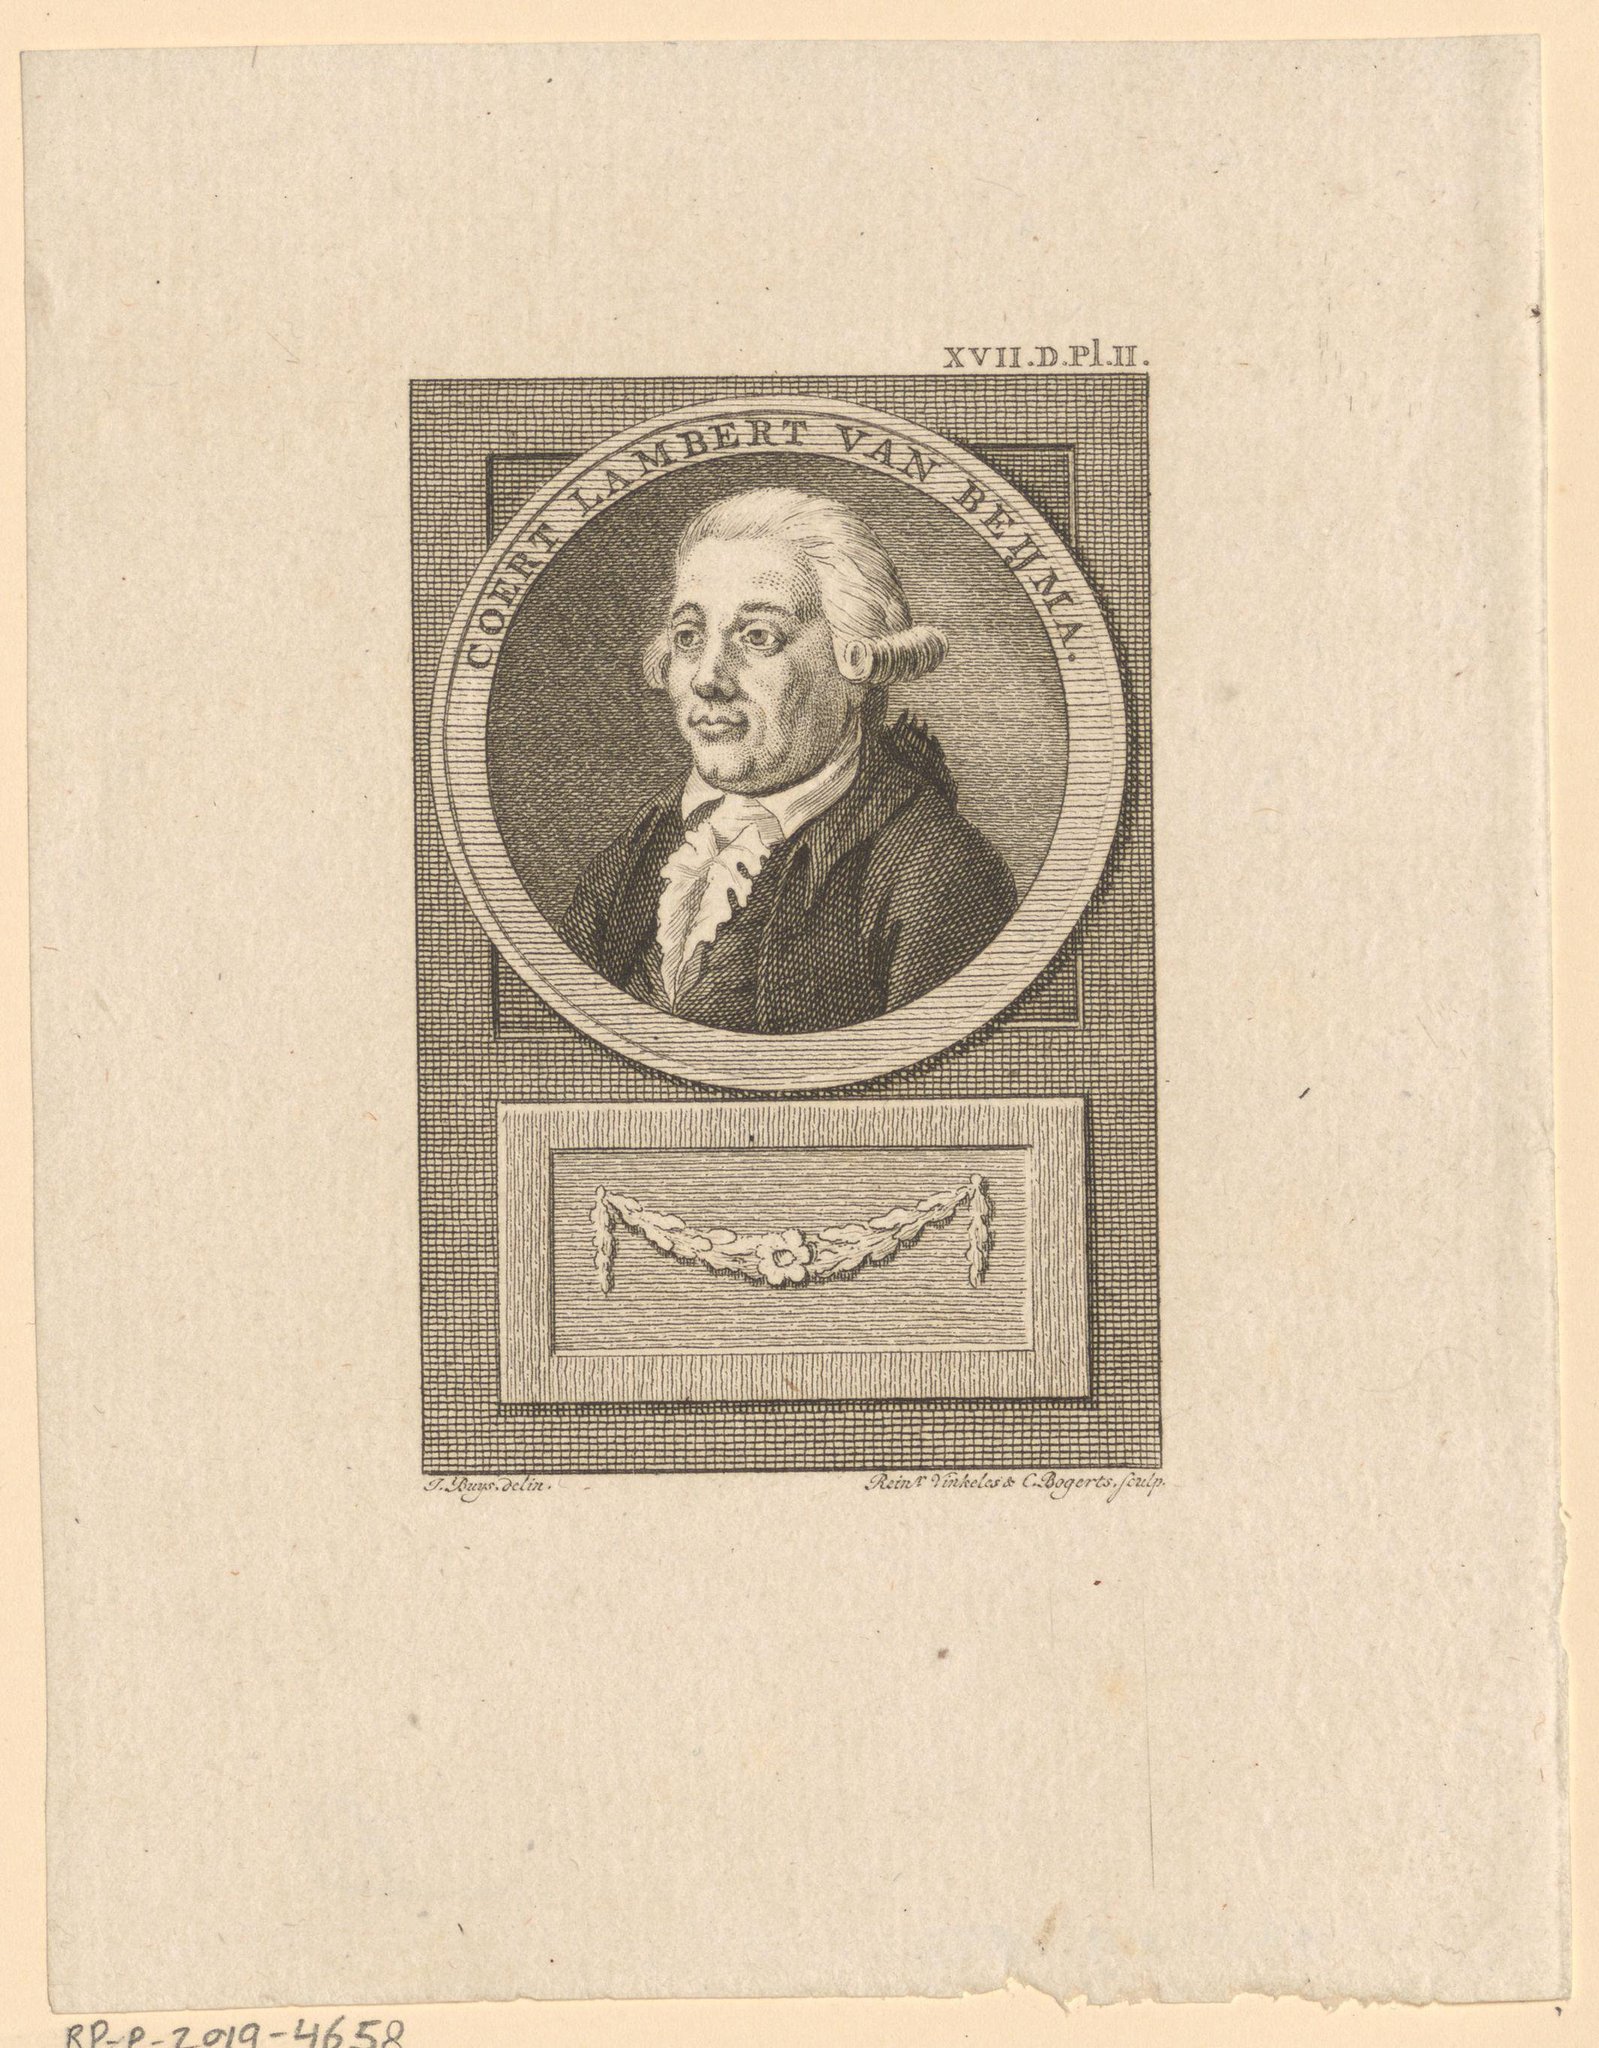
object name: book illustration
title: Portret van Coert Lambertus van Beyma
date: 1783-1795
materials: paper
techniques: engraving, etching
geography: amsterdam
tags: harlingen, historical persons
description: Prent uit: Fokke, Jan. Geschiedenissen der Vereenigde Nederlanden voor de vaderlandsche jeugd. 25 dln. Amsterdam: Johannes Allart, 1783-1795, dl. 17.